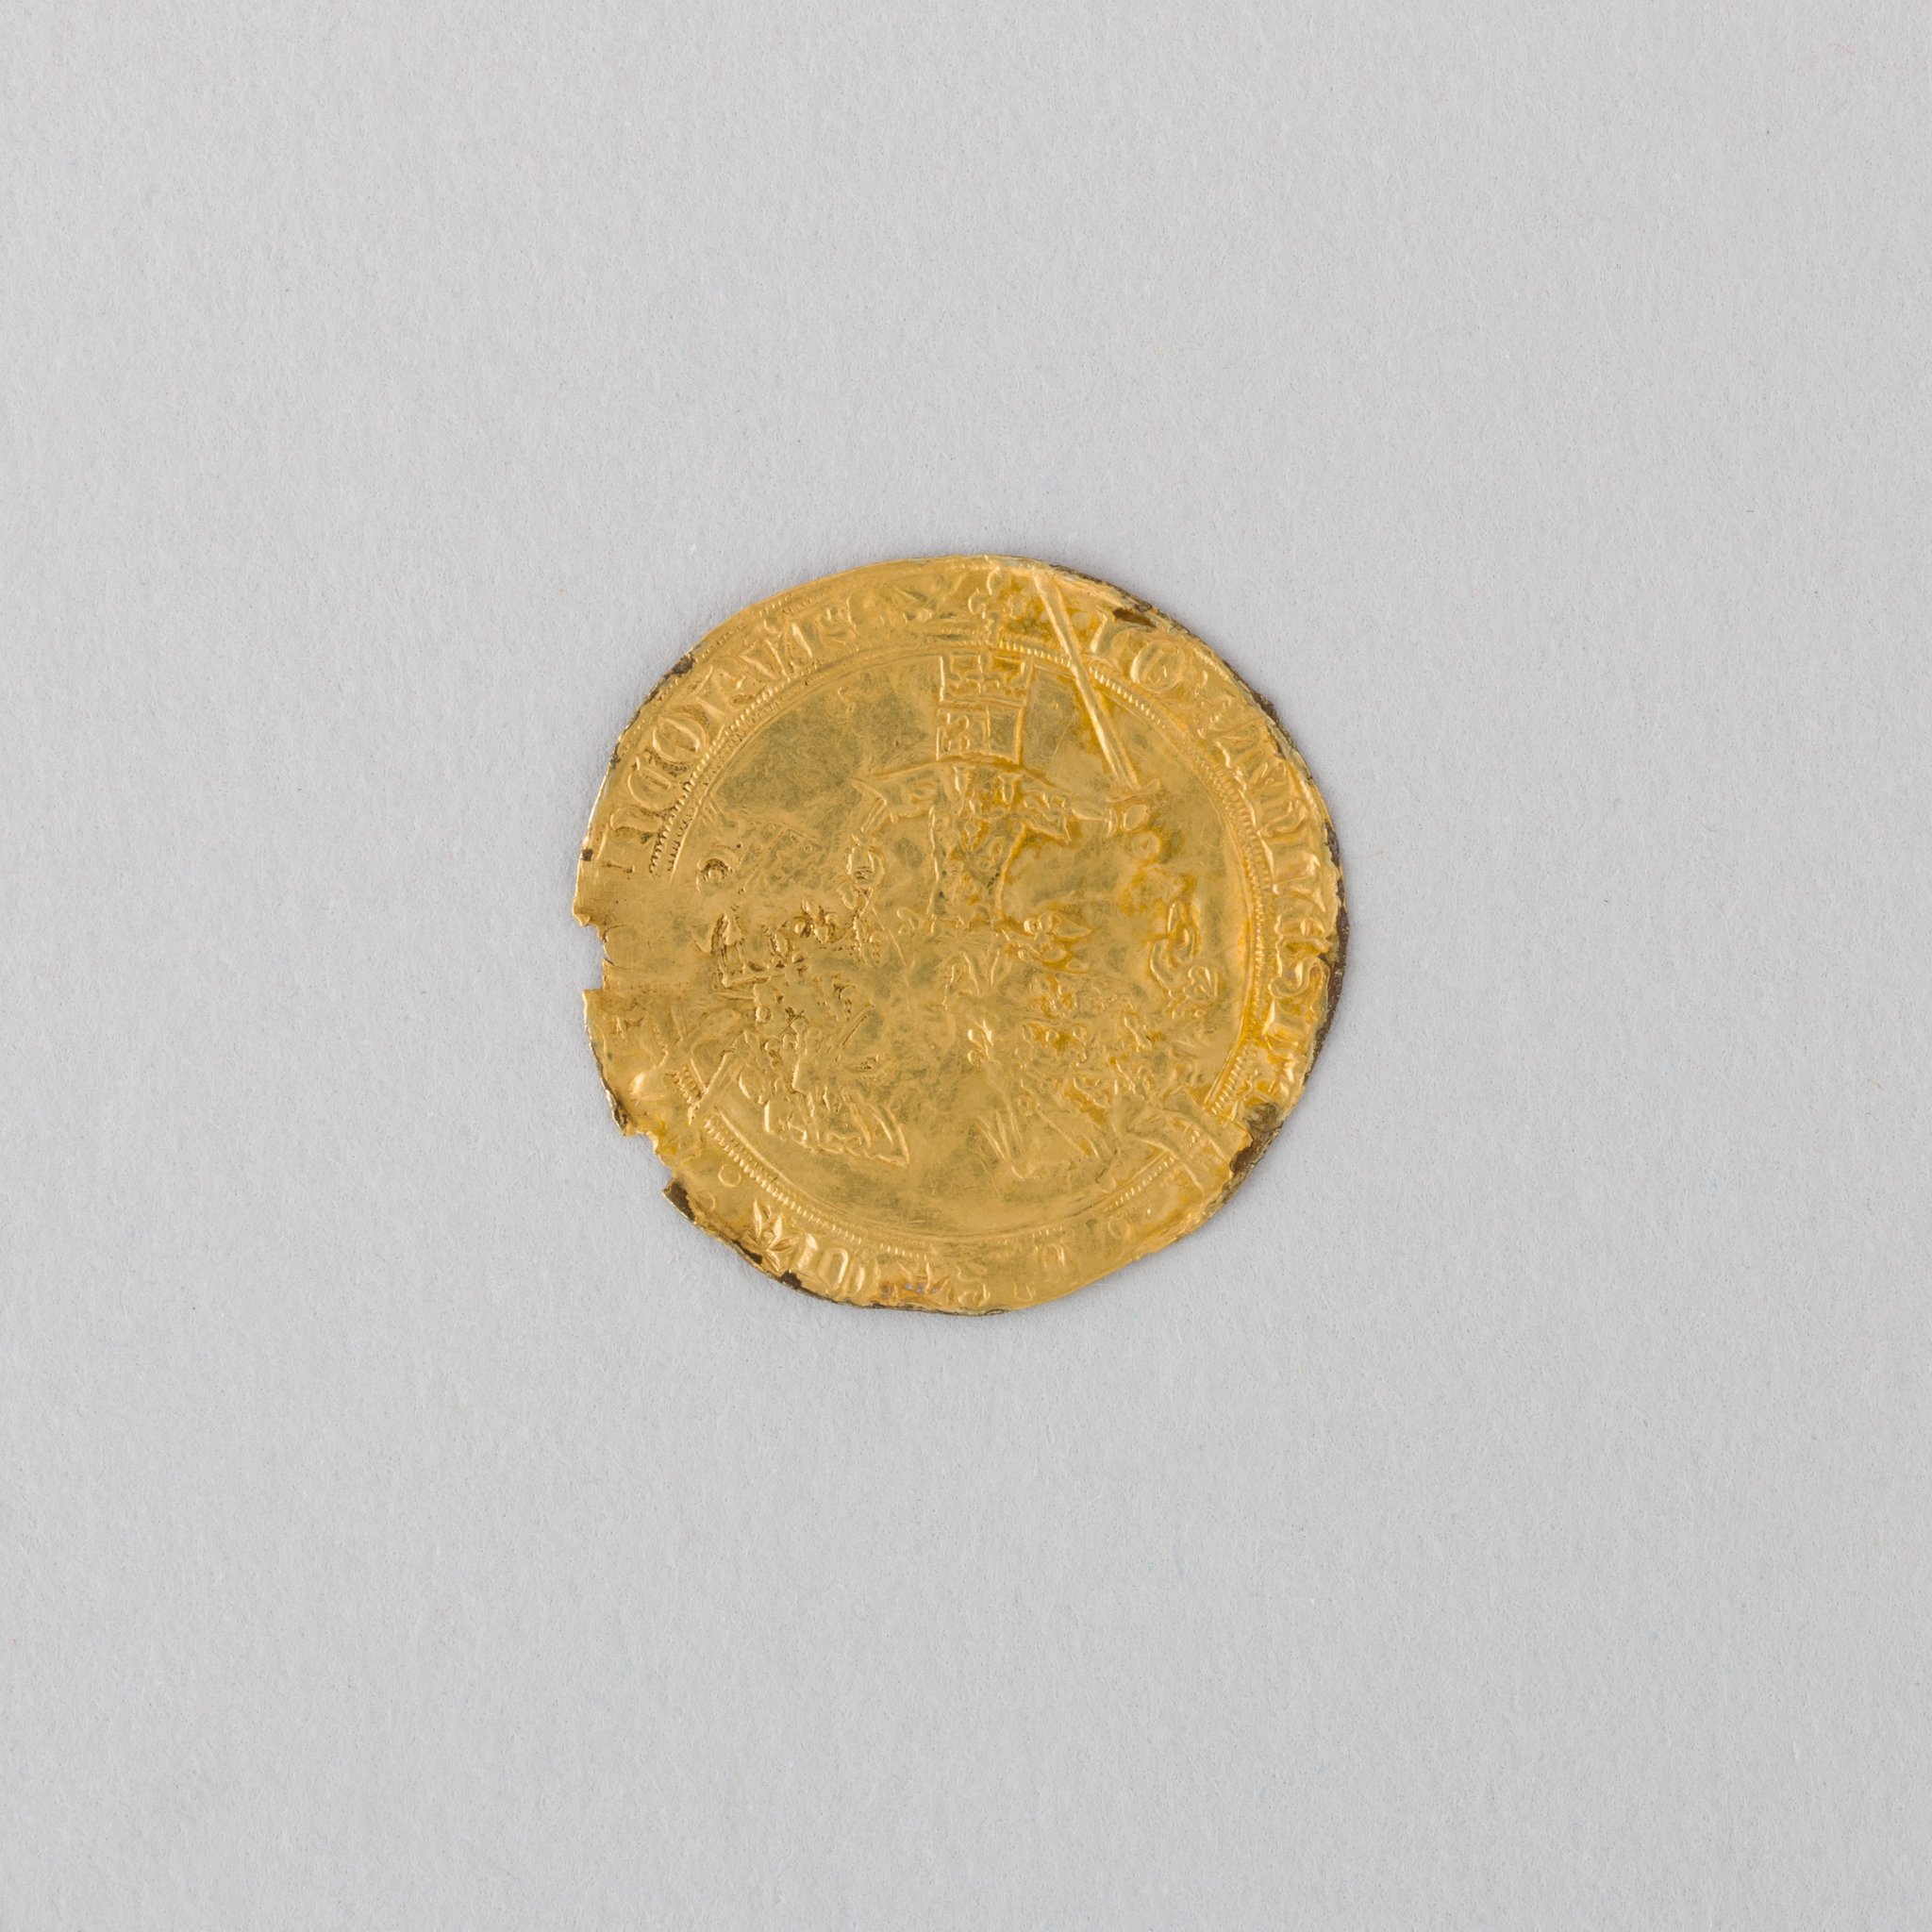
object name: coin franc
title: Coin (Franc) Showing Jean le Bon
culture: french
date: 1350-1364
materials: gold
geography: france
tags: kings,coins